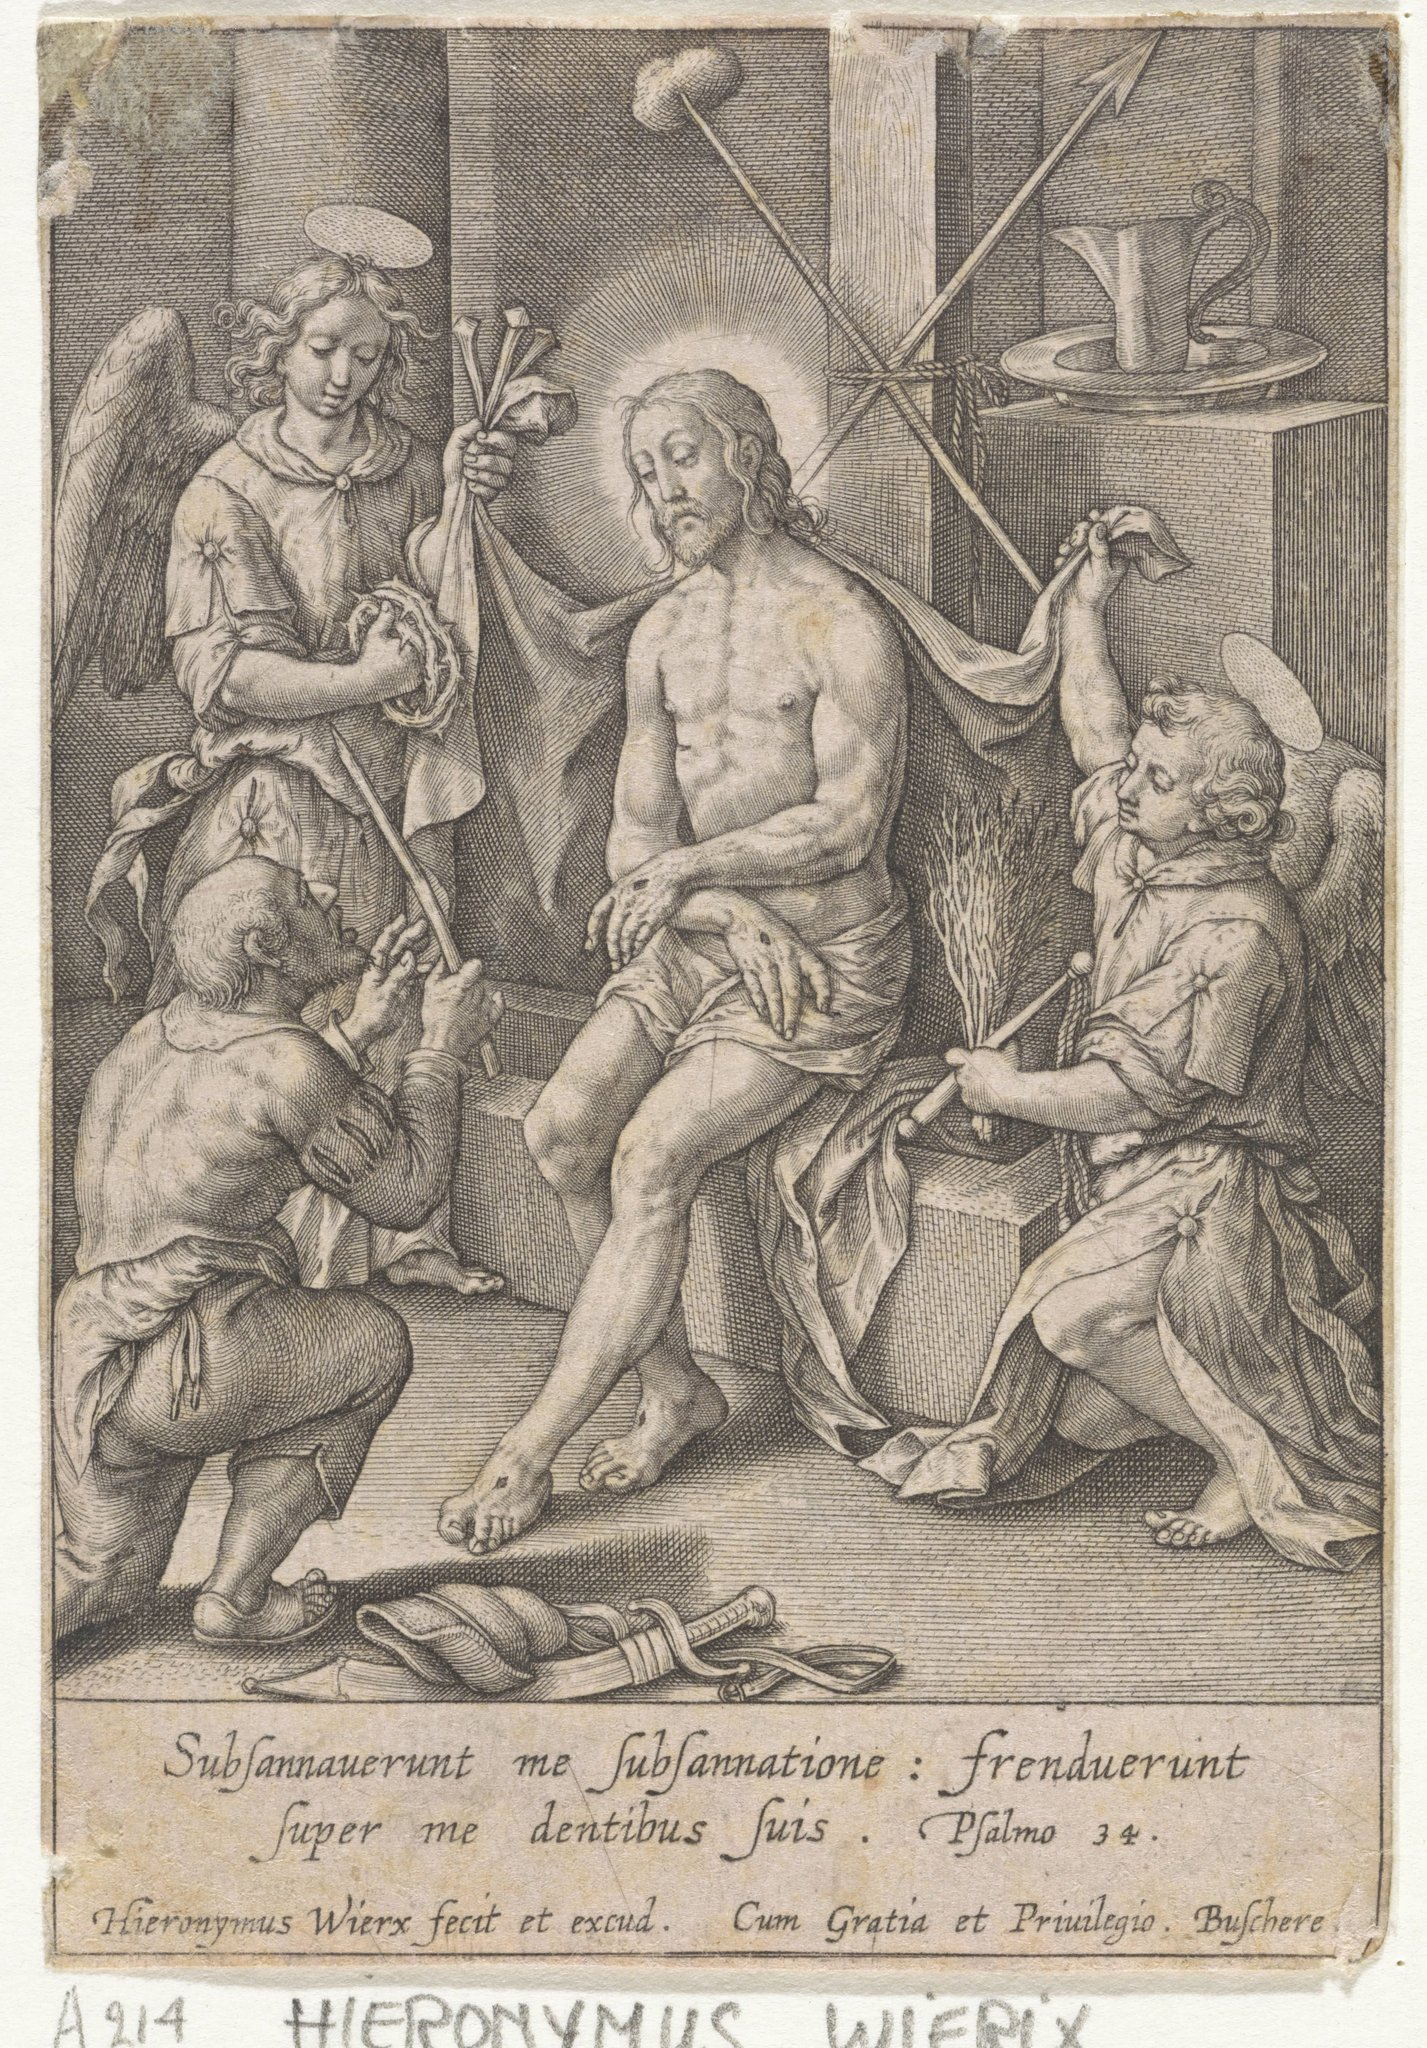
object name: print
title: Christus als man van smarten, vergezeld door engelen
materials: paper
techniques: engraving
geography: antwerp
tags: reed ~ instruments of the passion, man of sorrows, 'imago pietatis', 'erbärmdebild', 'schmerzensmann'; the upright christ showing his wounds, usually bearing the crown of thorns, and accompanied by the instruments of the passion, standing or sitting in his tomb (+ angel(s))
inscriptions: collector's mark: Lugt 2228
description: Christus zit aan de voet van het kruis en toont zijn wonden. Aan weerszijden van hem engelen met de passiewerktuigen. Een geknielde man overhandigt de rietstengel aan Christus. In de marge een tweeregelig Bijbelcitaat uit Ps. 34 in het Latijn.